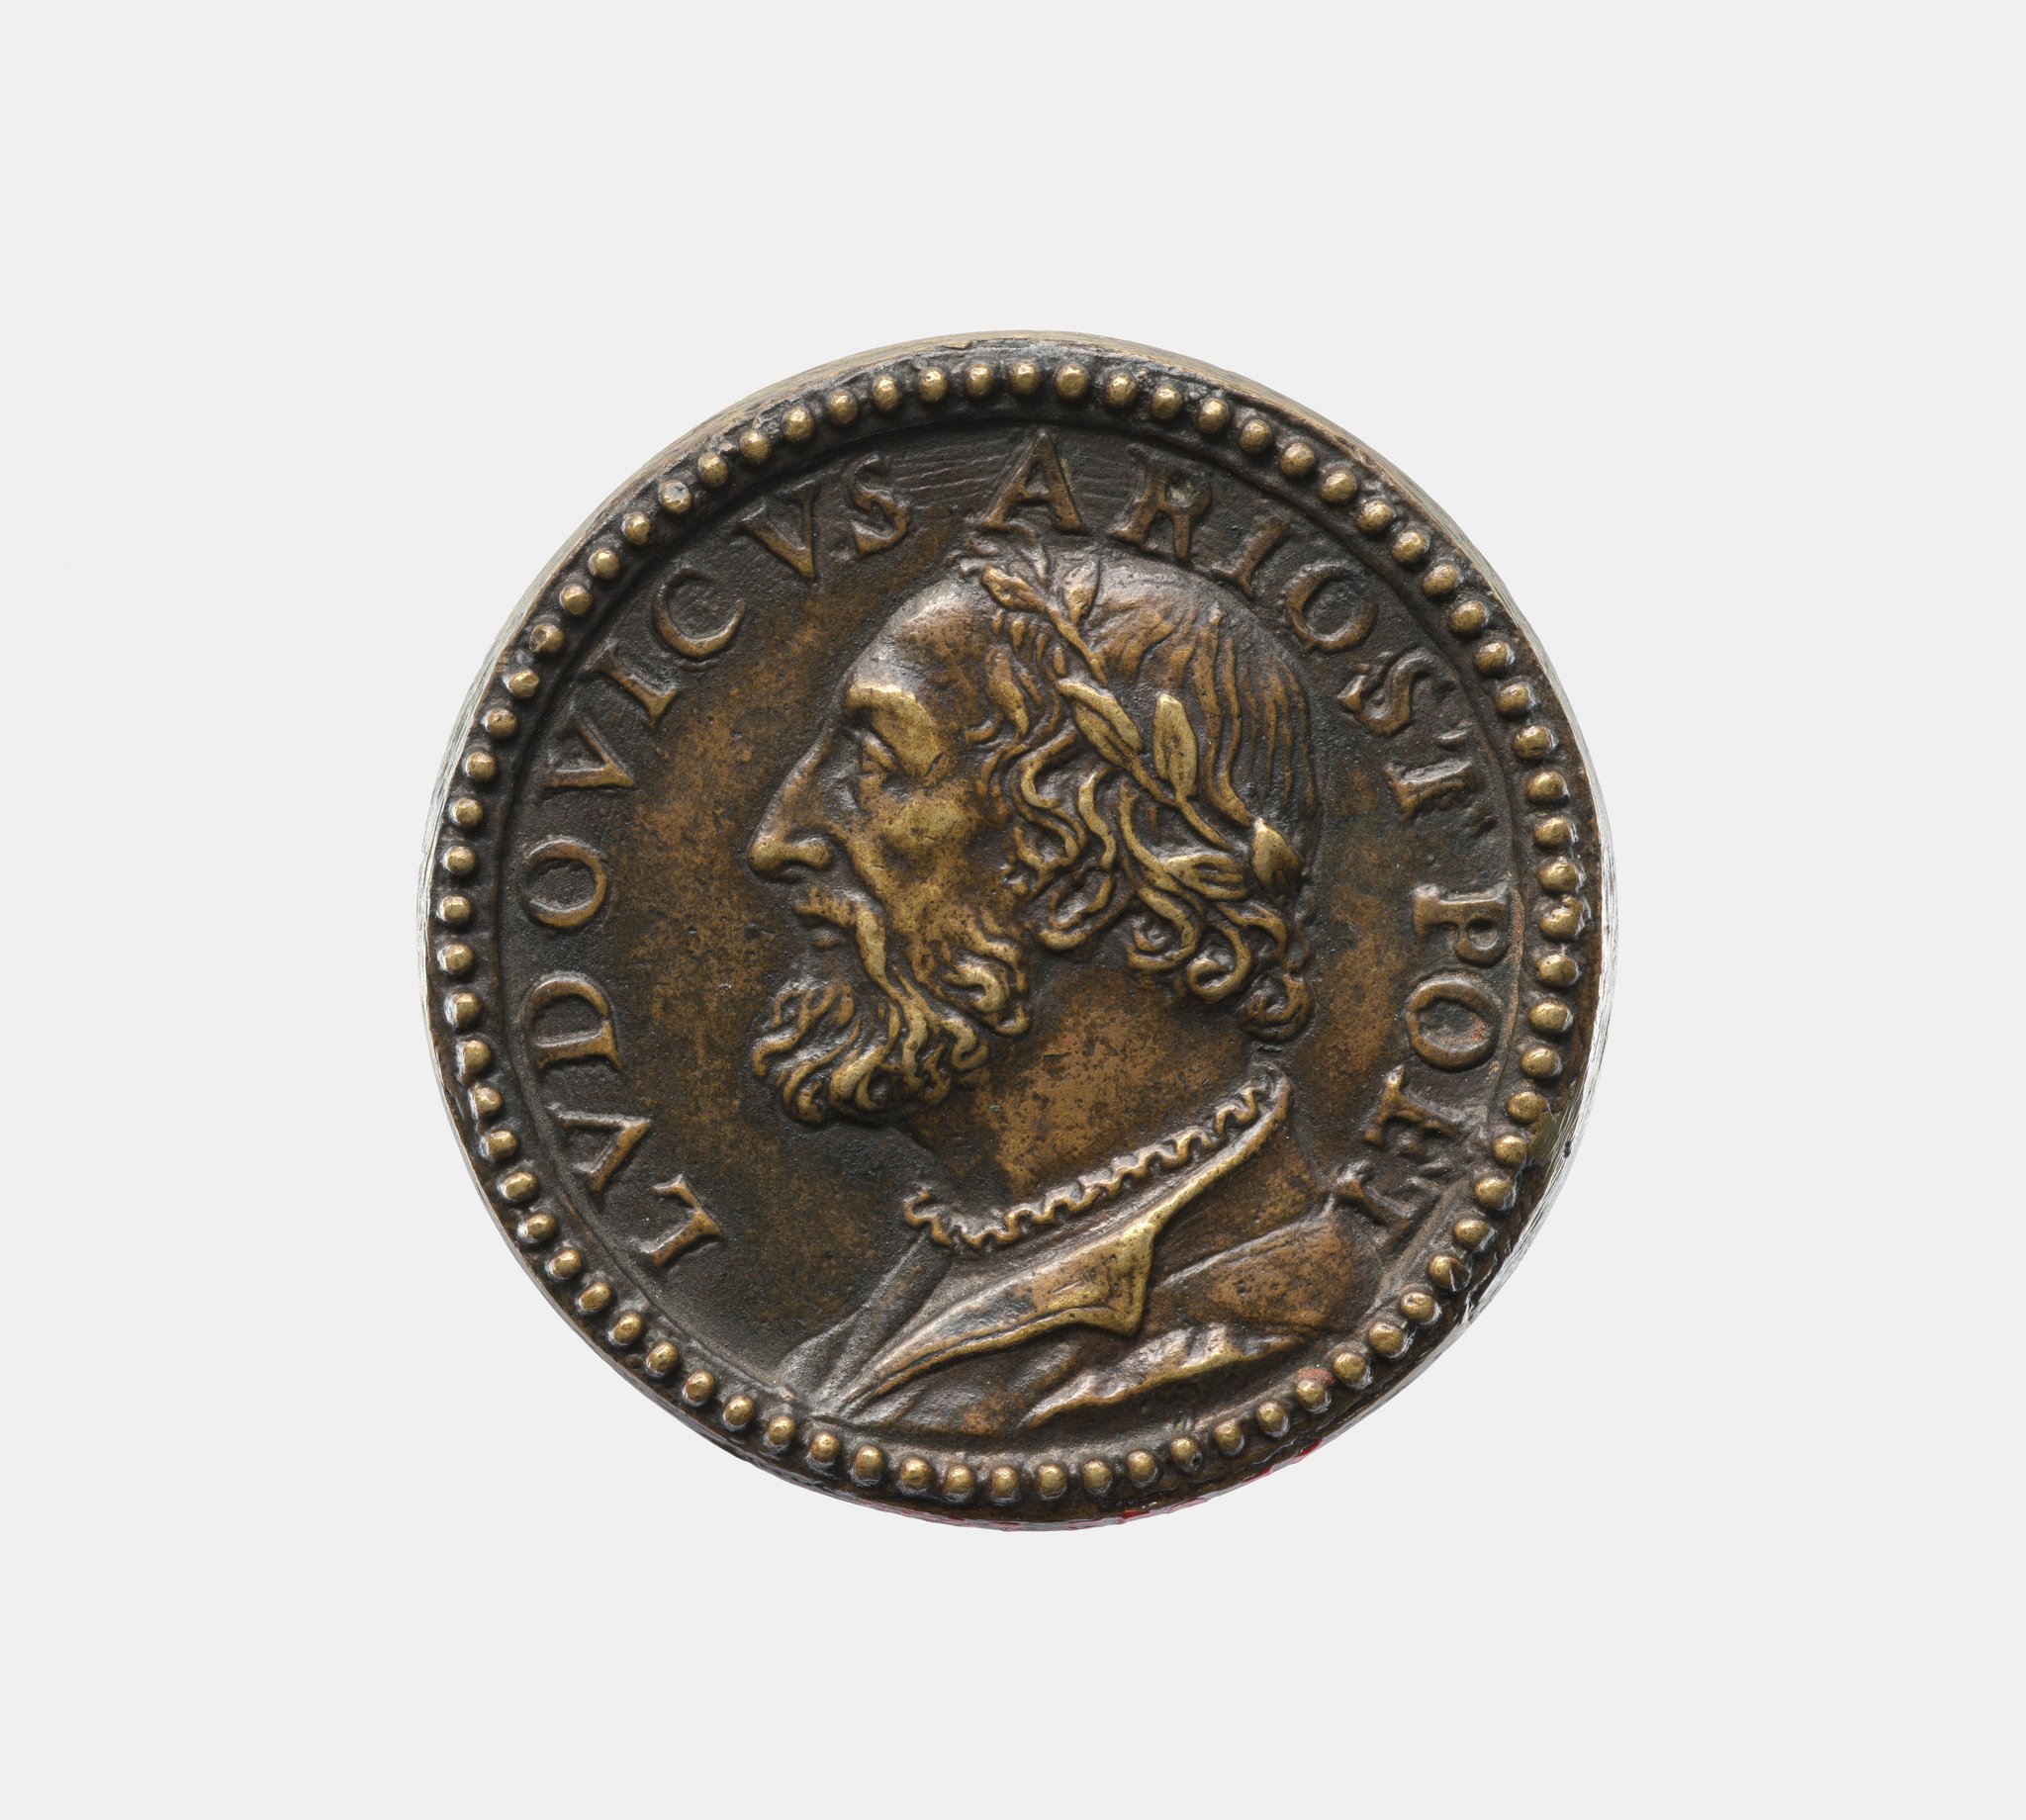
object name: medal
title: Lodovico Ariosto 1474-1533, poet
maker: pastorino di giovan michele de' pastorini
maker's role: artist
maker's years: 1508-1592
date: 1508-1592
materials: bronze